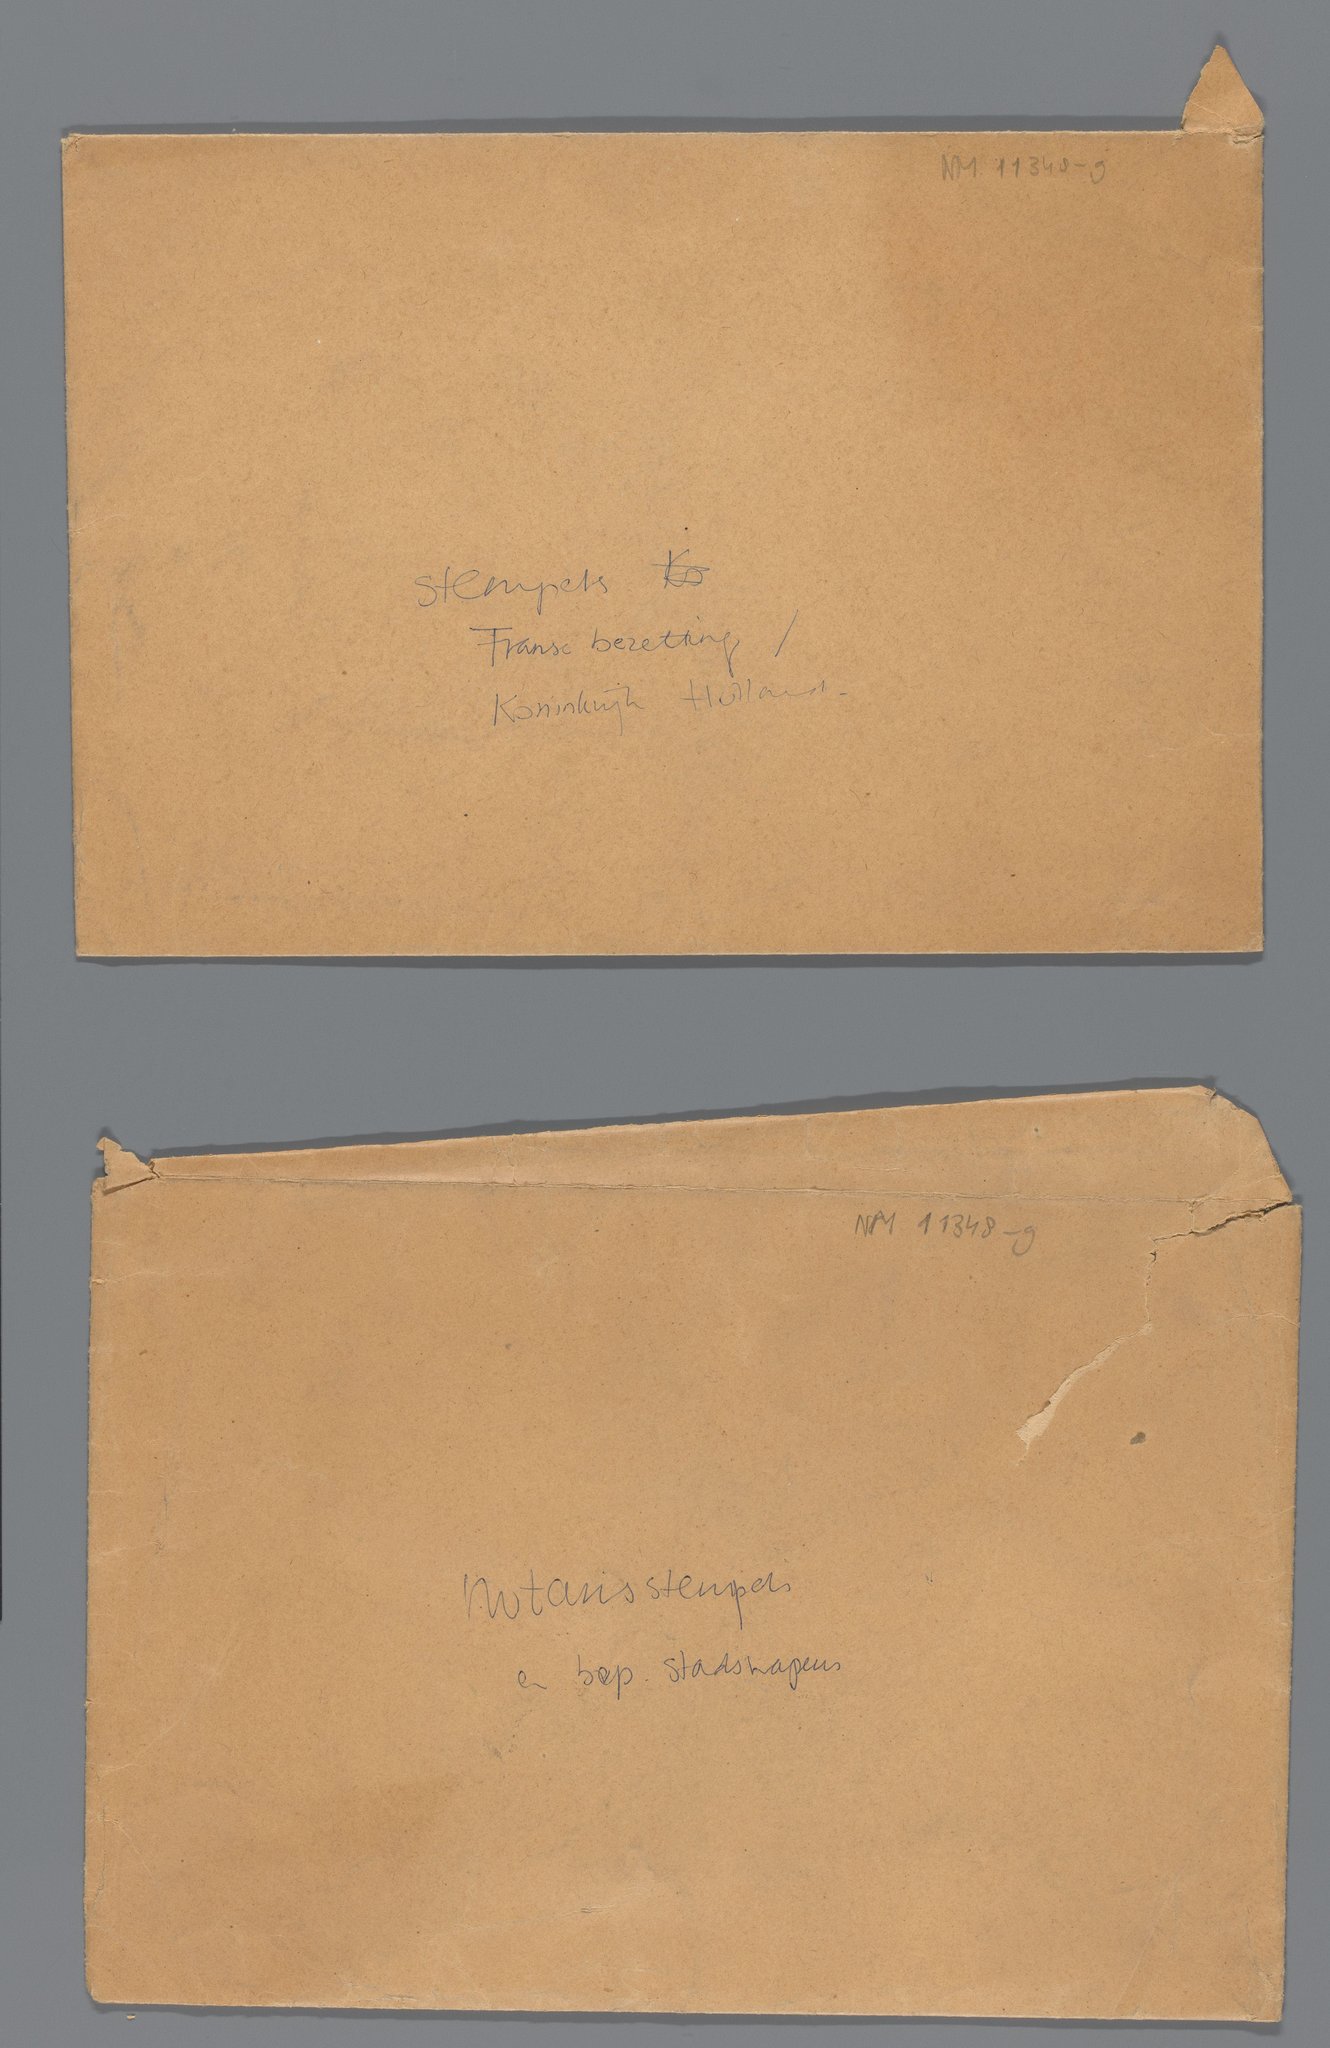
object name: zegelafdruk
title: Diverse zegels en bladen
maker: Anonymous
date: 1633-1844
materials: ink, paper, parchment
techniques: blind stamped, printing, writing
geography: netherlands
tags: netherlands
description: Acht melinexmappen met in totaal ca. 1200 losse uitgeknipte zegels en bladen papier uit de 17e-19e eeuw, afkomstig van officiële Nederlandse overheidsinstanties. Onderdeel van mappen met zegels en documenten (NG-NM-11348-A t/m I).